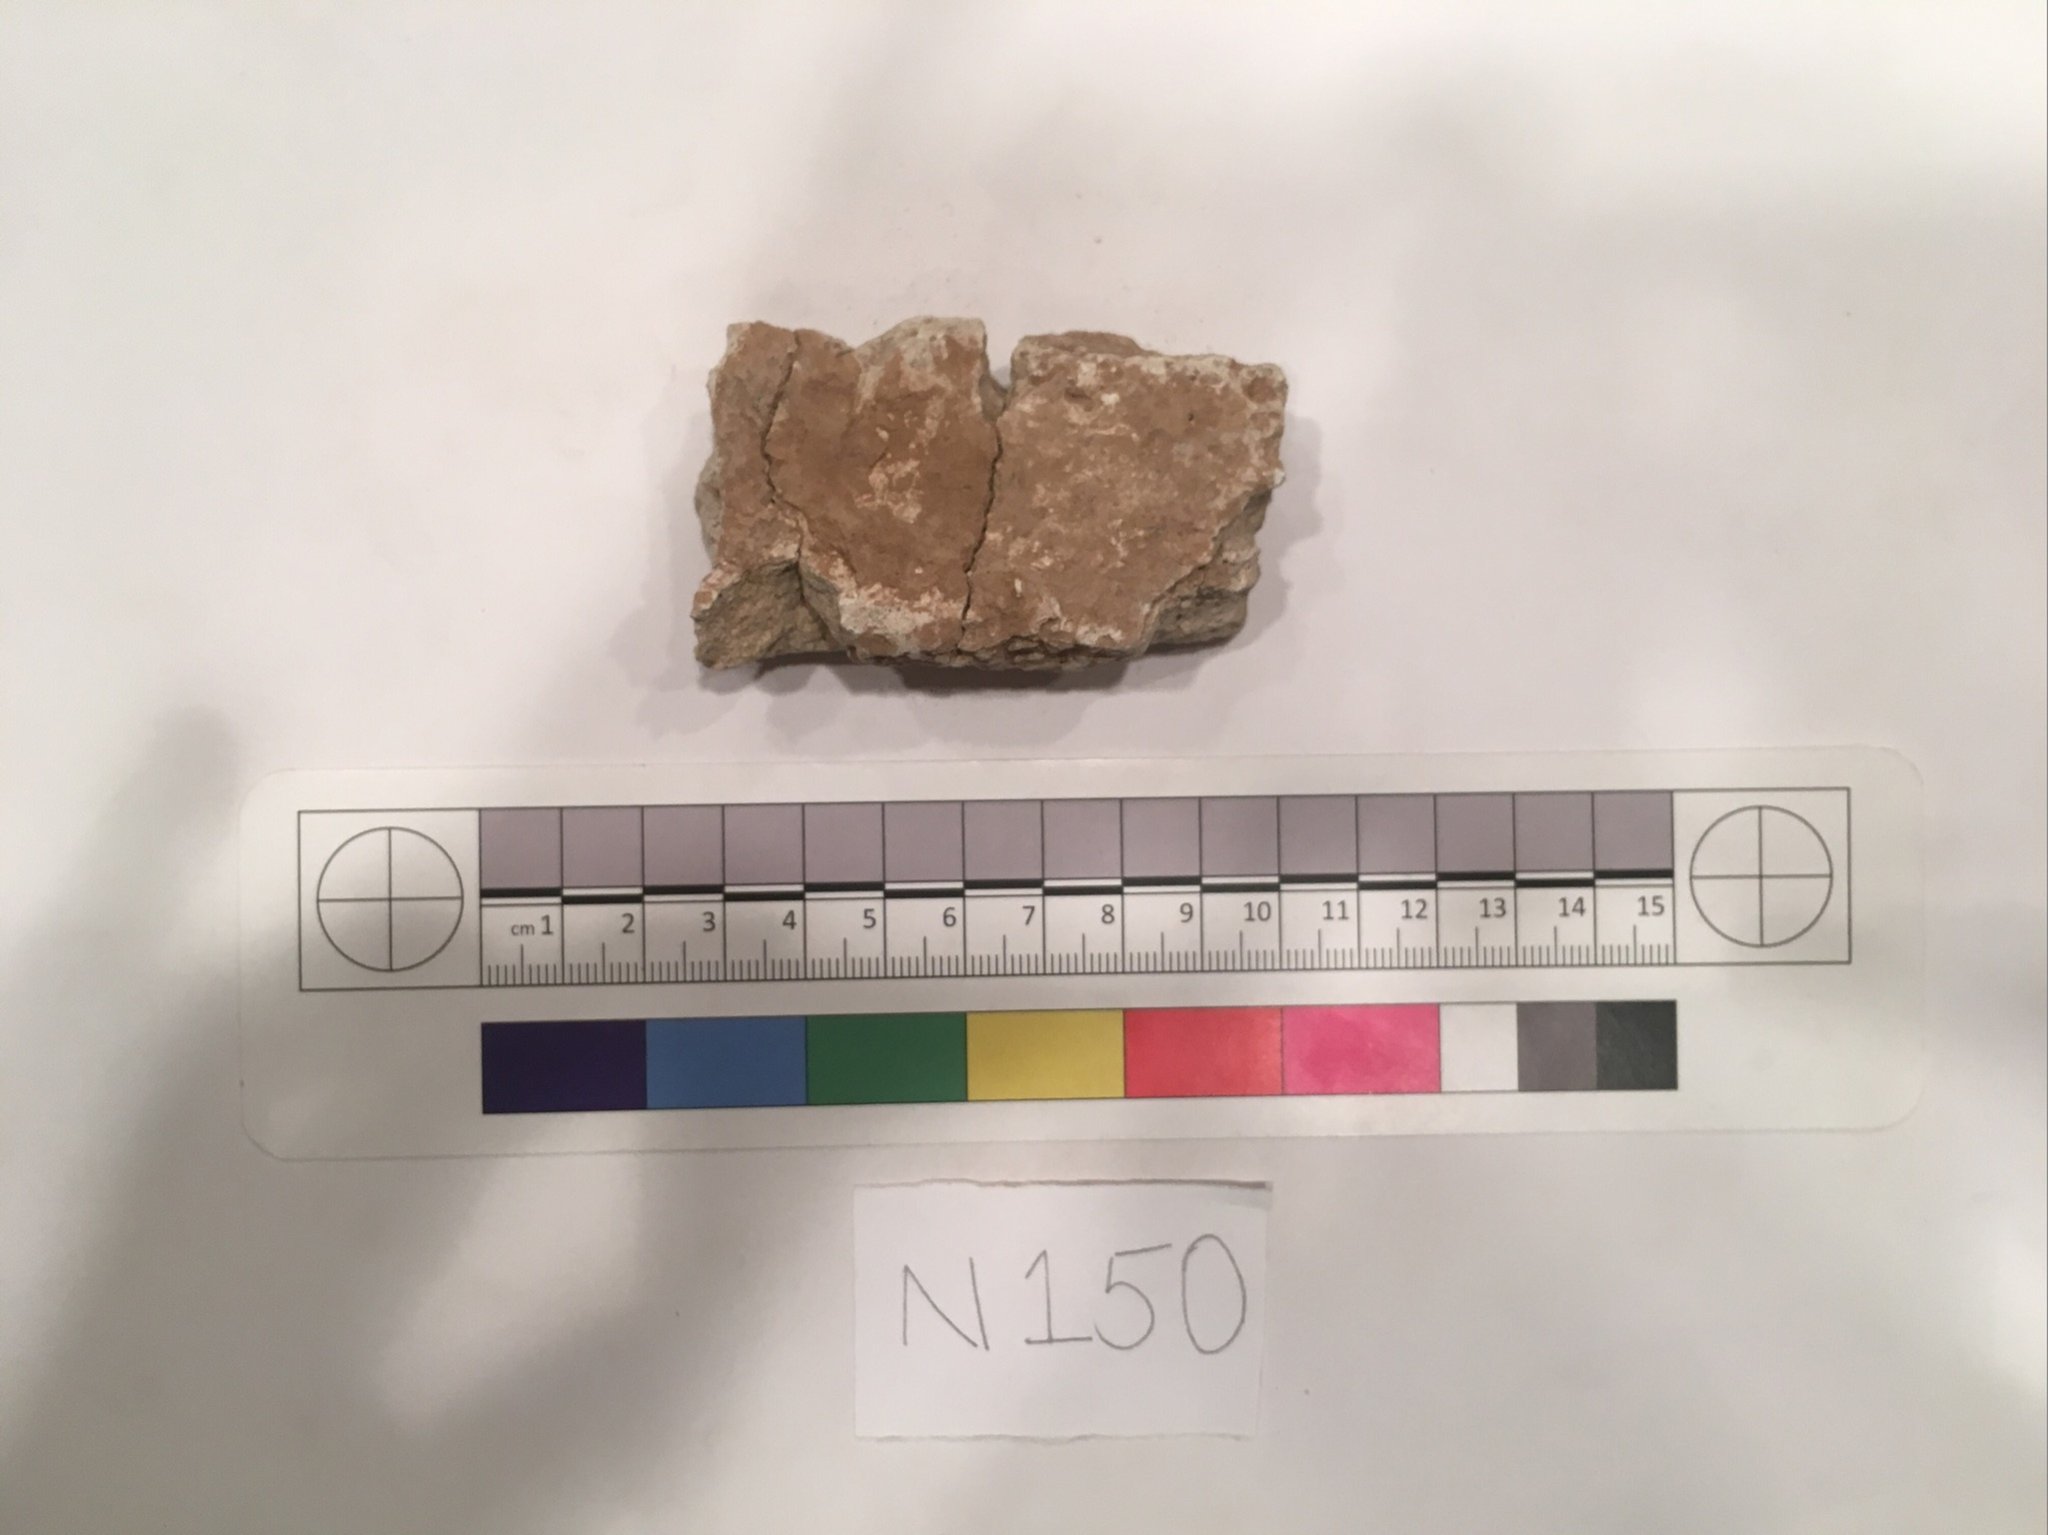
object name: fragment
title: Stucco Fragment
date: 701-1200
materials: plaster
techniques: carving, painting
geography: iran